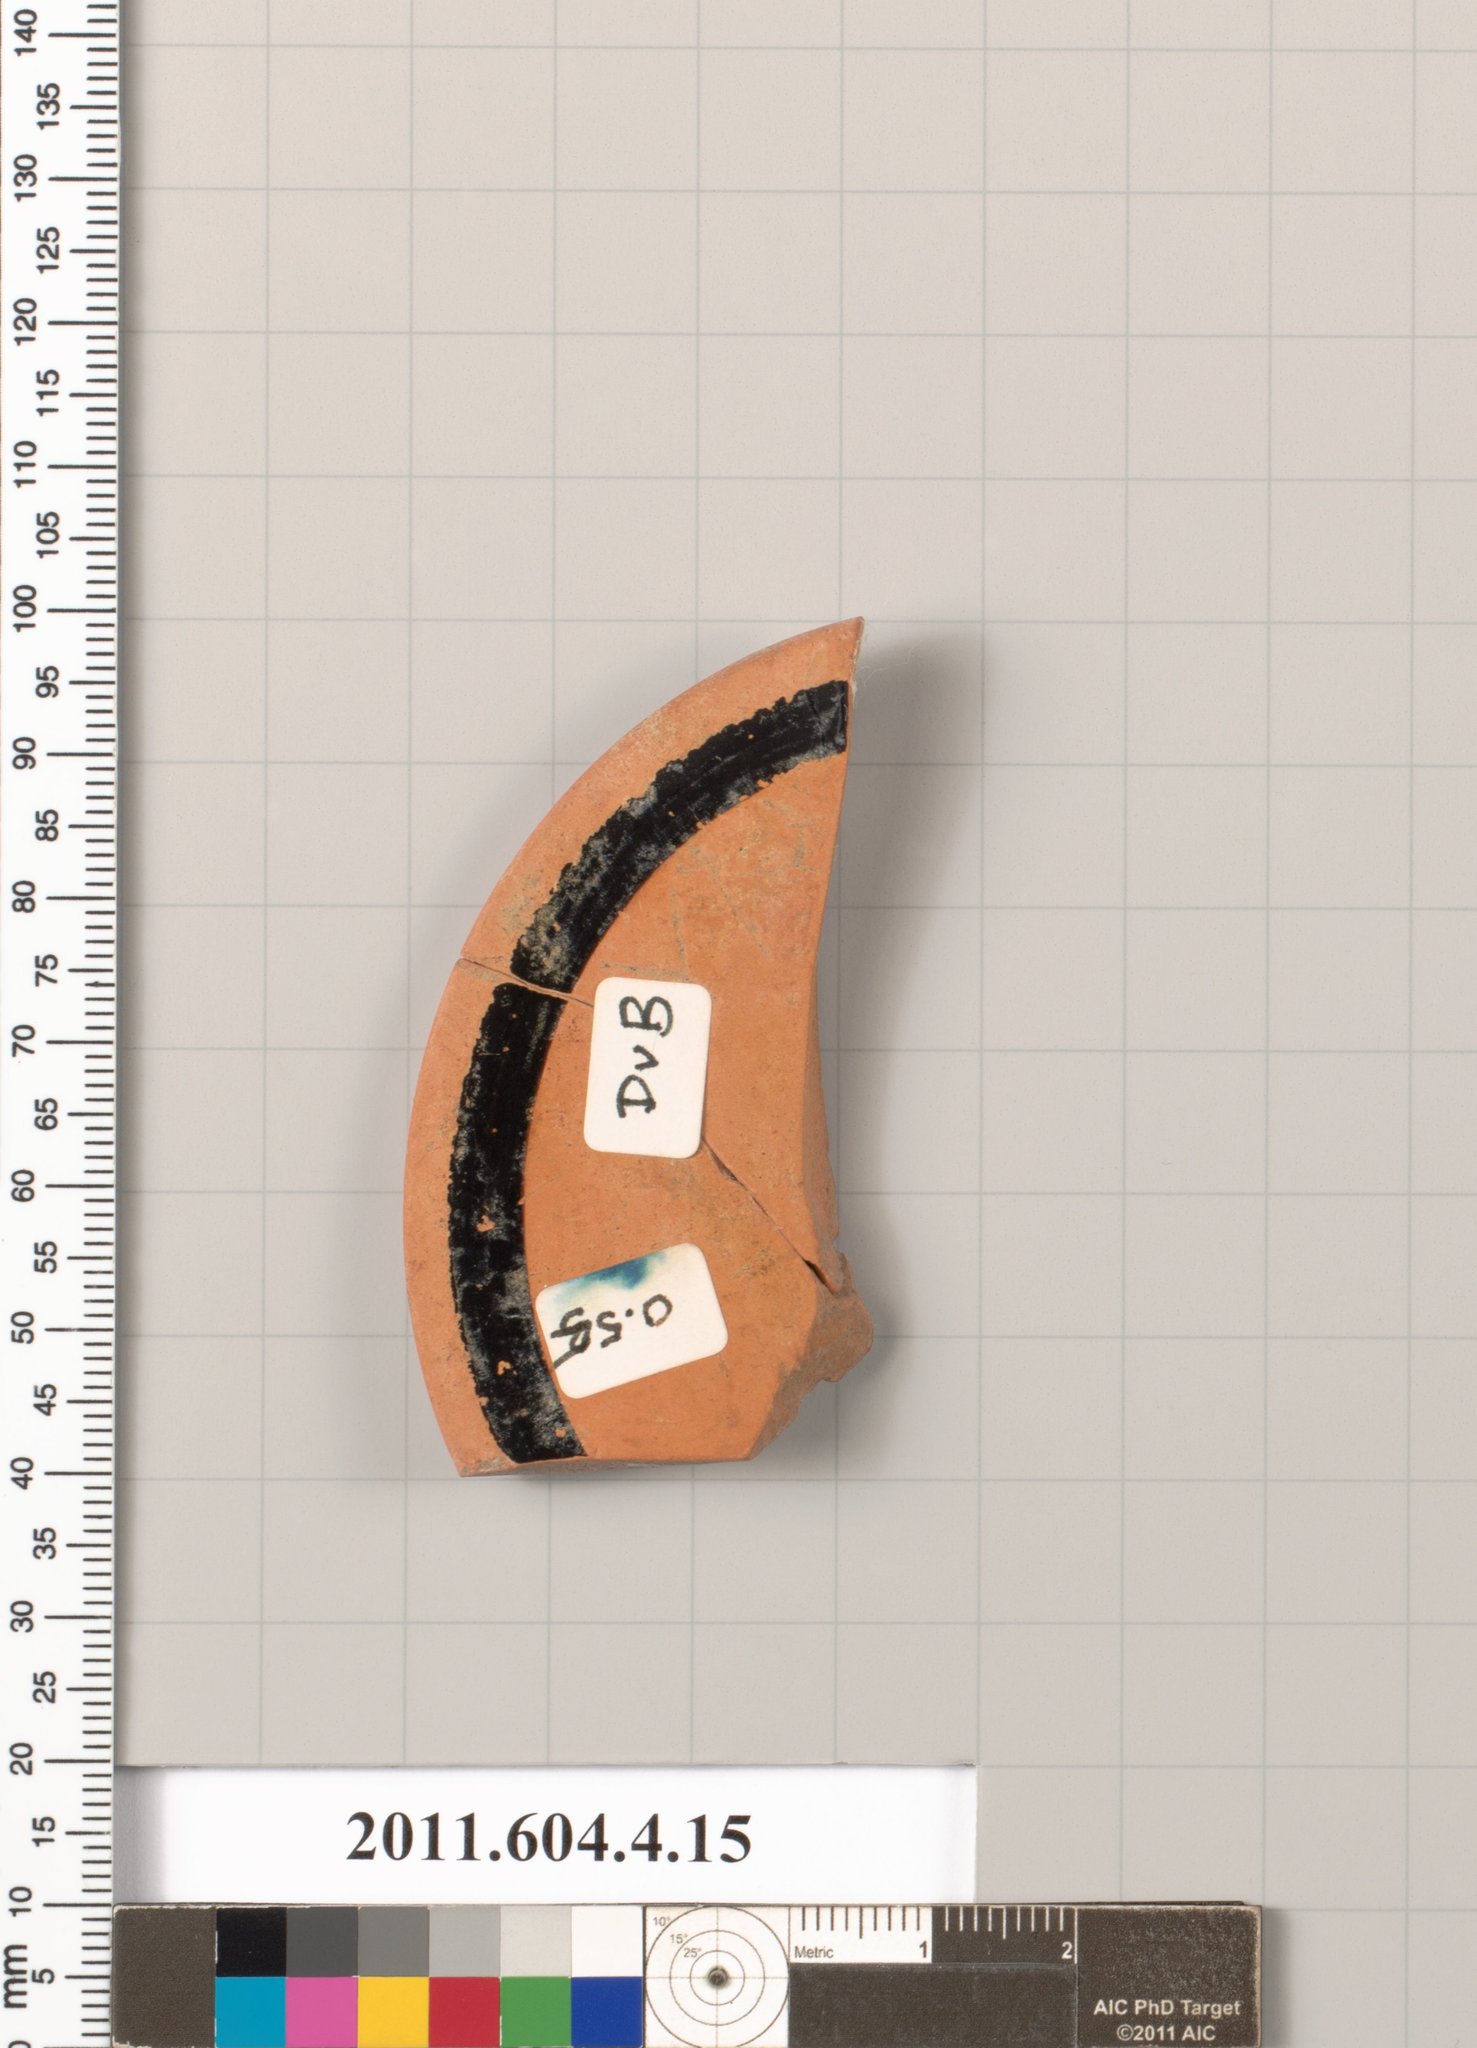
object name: kylix fragment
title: Terracotta fragment of a kylix (drinking cup)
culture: greek, attic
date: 500-401 BCE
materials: terracotta